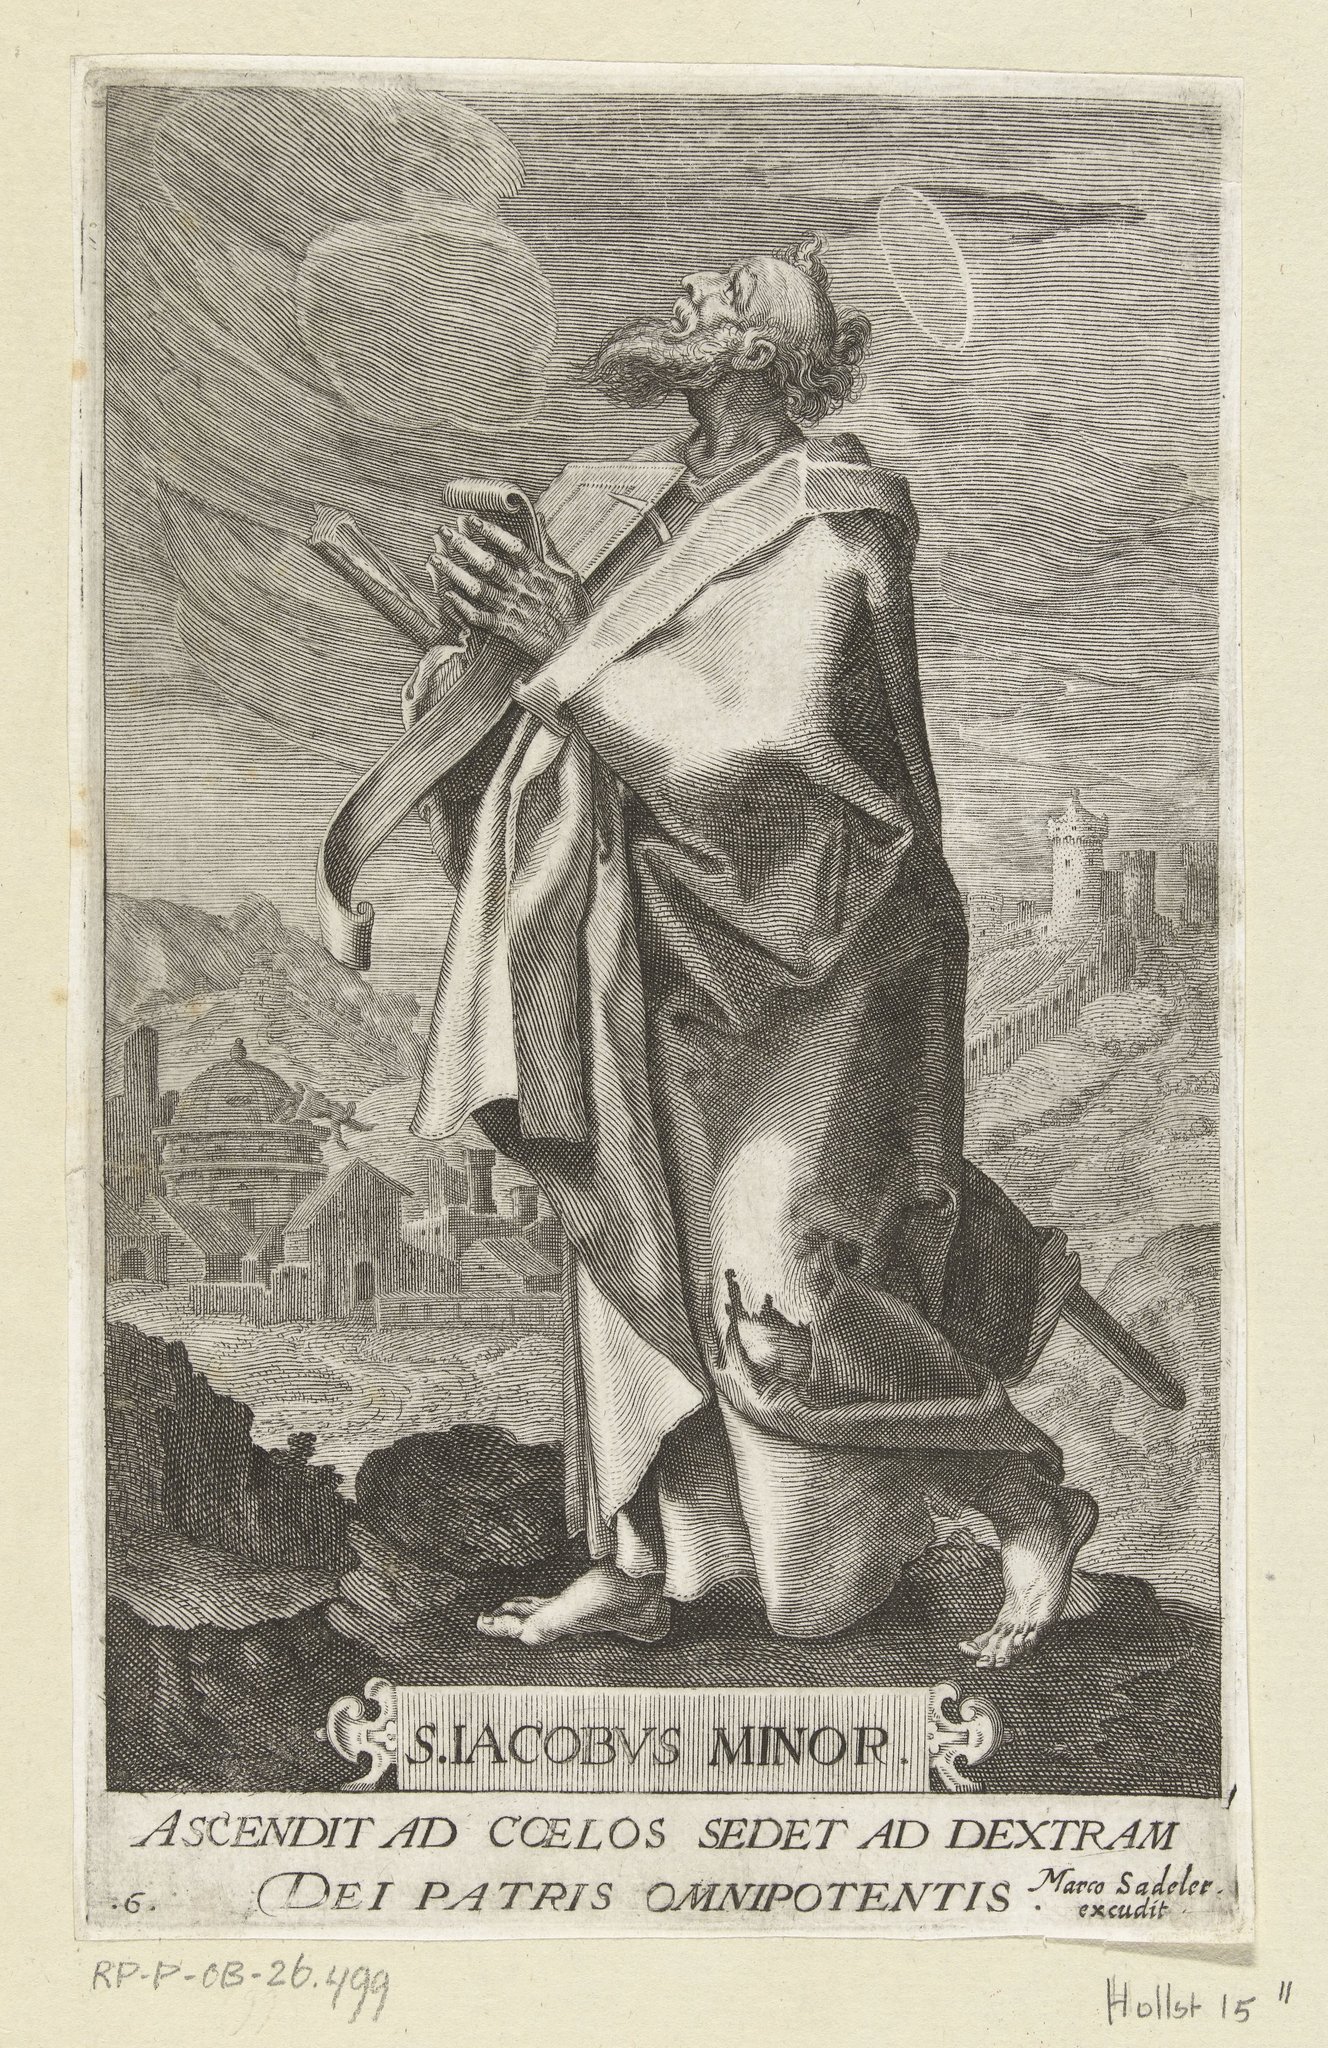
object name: print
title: Apostel Jakobus de Mindere (Jacobus Minor)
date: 1591-1629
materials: paper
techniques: engraving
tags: the apostle james the less, first bishop of jerusalem; possible attributes: book, fuller's club, scroll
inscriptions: collector's mark: Lugt 240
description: Apostel Jakobus de Mindere (Jacobus Minor) met boek en staf. Op de achtergrond is een scène uit het leven van de heilige weergegeven, hij sterft de marteldood bij een val van het dak van de tempel. Onder de voorstelling staat een Latijnse regel uit de apostolische geloofsbelijdenis.